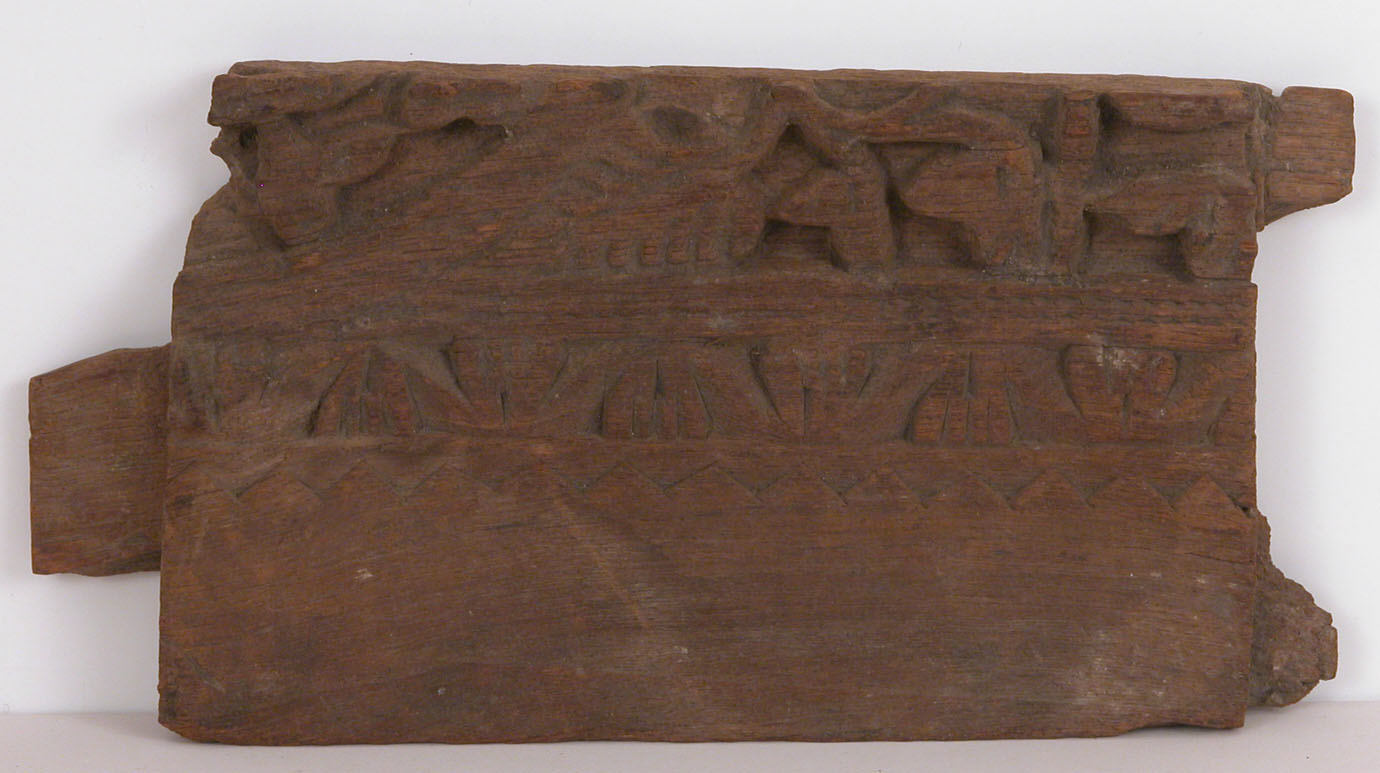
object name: panel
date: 701-900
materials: wood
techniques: carving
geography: iraq